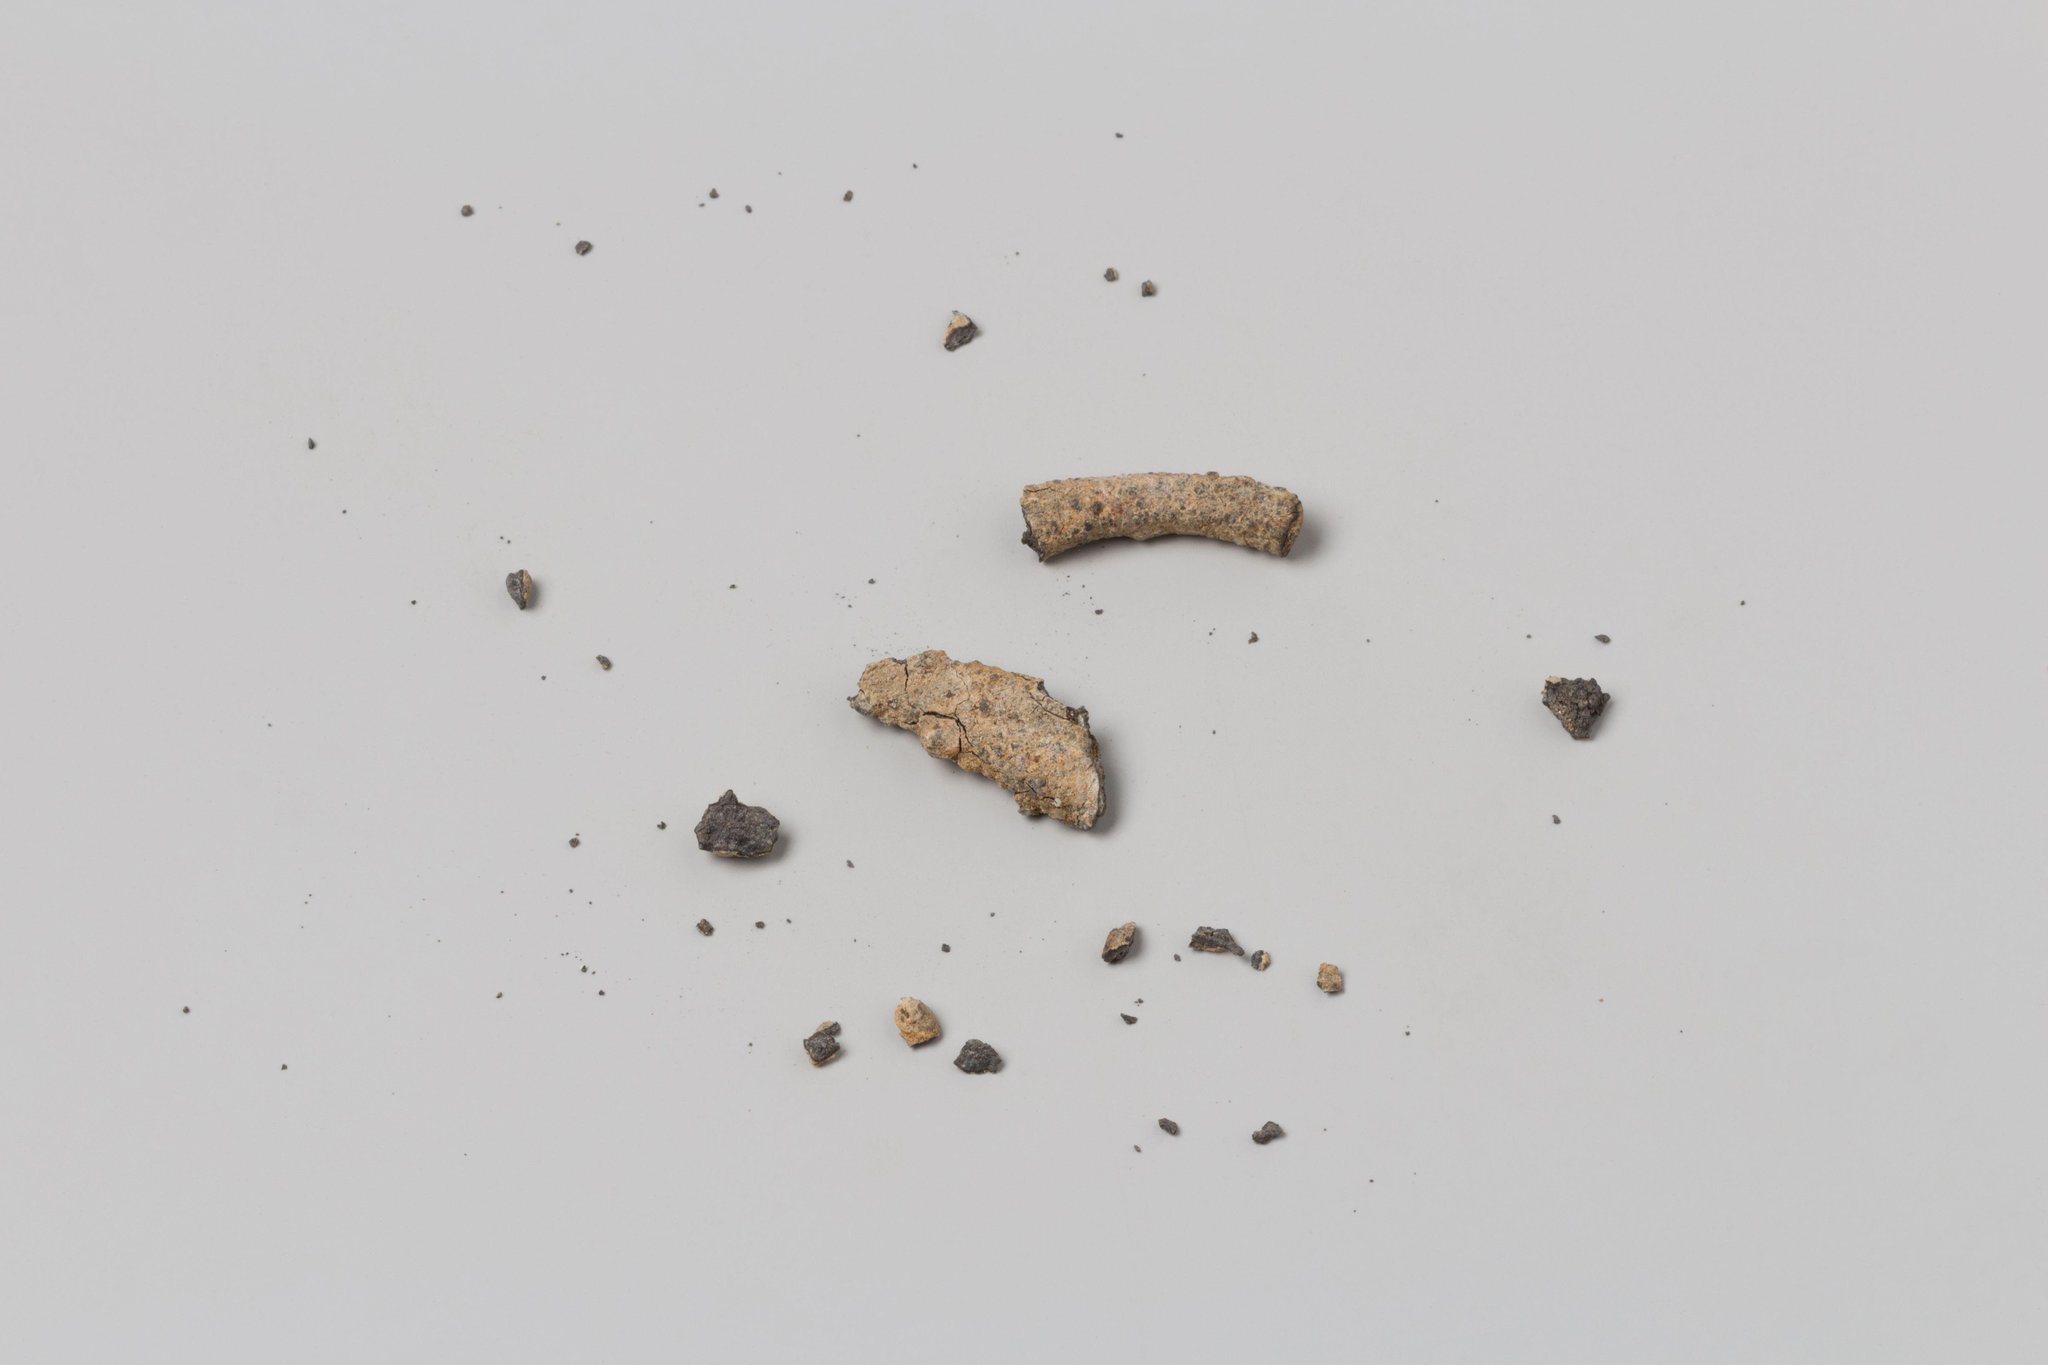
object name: spoon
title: Gefragmenteerde steel van vork of lepel uit het wrak van de Oost-Indiëvaarder Hollandia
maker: Anonymous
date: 1700-1743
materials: tin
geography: netherlands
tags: verenigde oostindische compagnie, hollandia (schip), annet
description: Cutlery, fragment: stem of fork or spoon; fragm, round in section, widening, corroded.